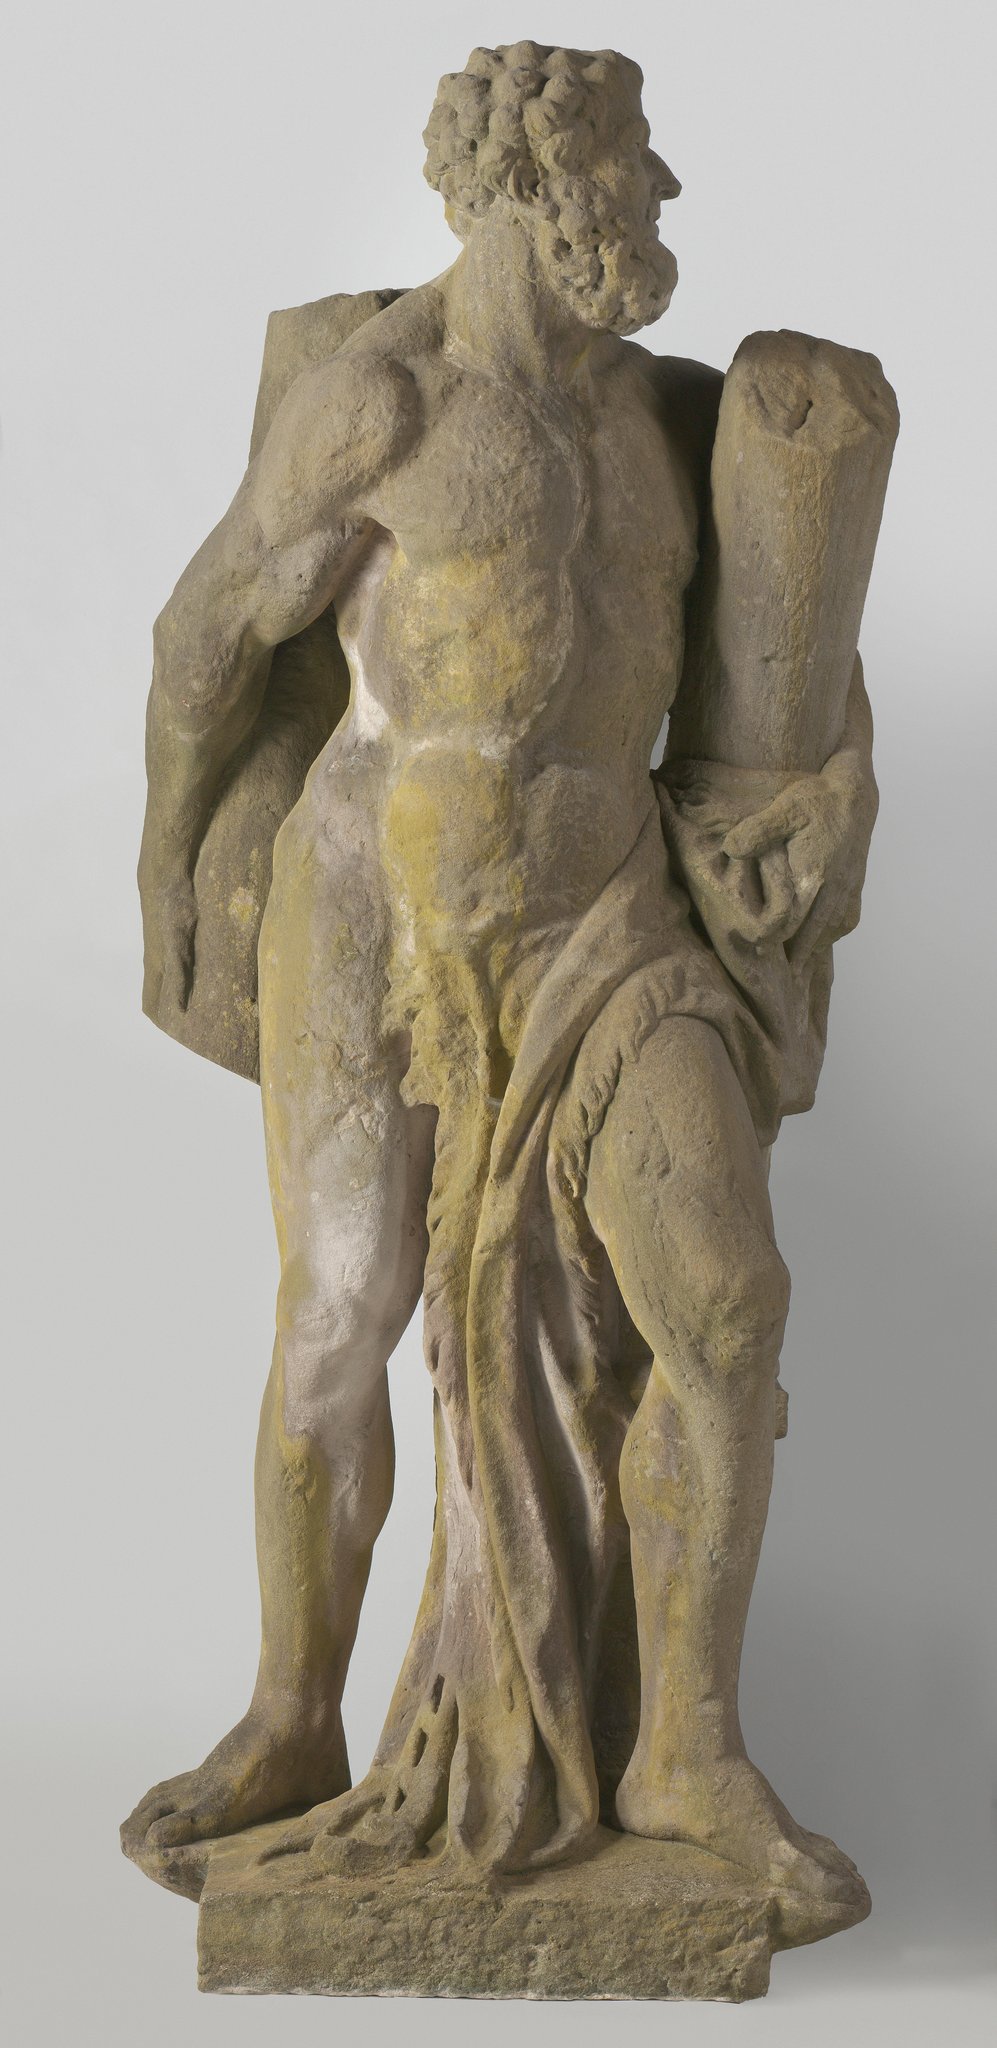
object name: tuinbeeld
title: Hercules with the Broken Column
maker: jan pieter van baurscheit (i)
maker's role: draughtsman, sculptor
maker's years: 1669-1728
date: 1722-1728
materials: stone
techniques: carved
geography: antwerp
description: This is one of a group of four statues, all of which are in this garden. The statues originally stood in the garden of Bosch en Hoven, a country estate near Haarlem. They were made by Jan Pieter Baurscheit the Elder, an Antwerp sculptor and architect often engaged by patrons in the Dutch Republic.